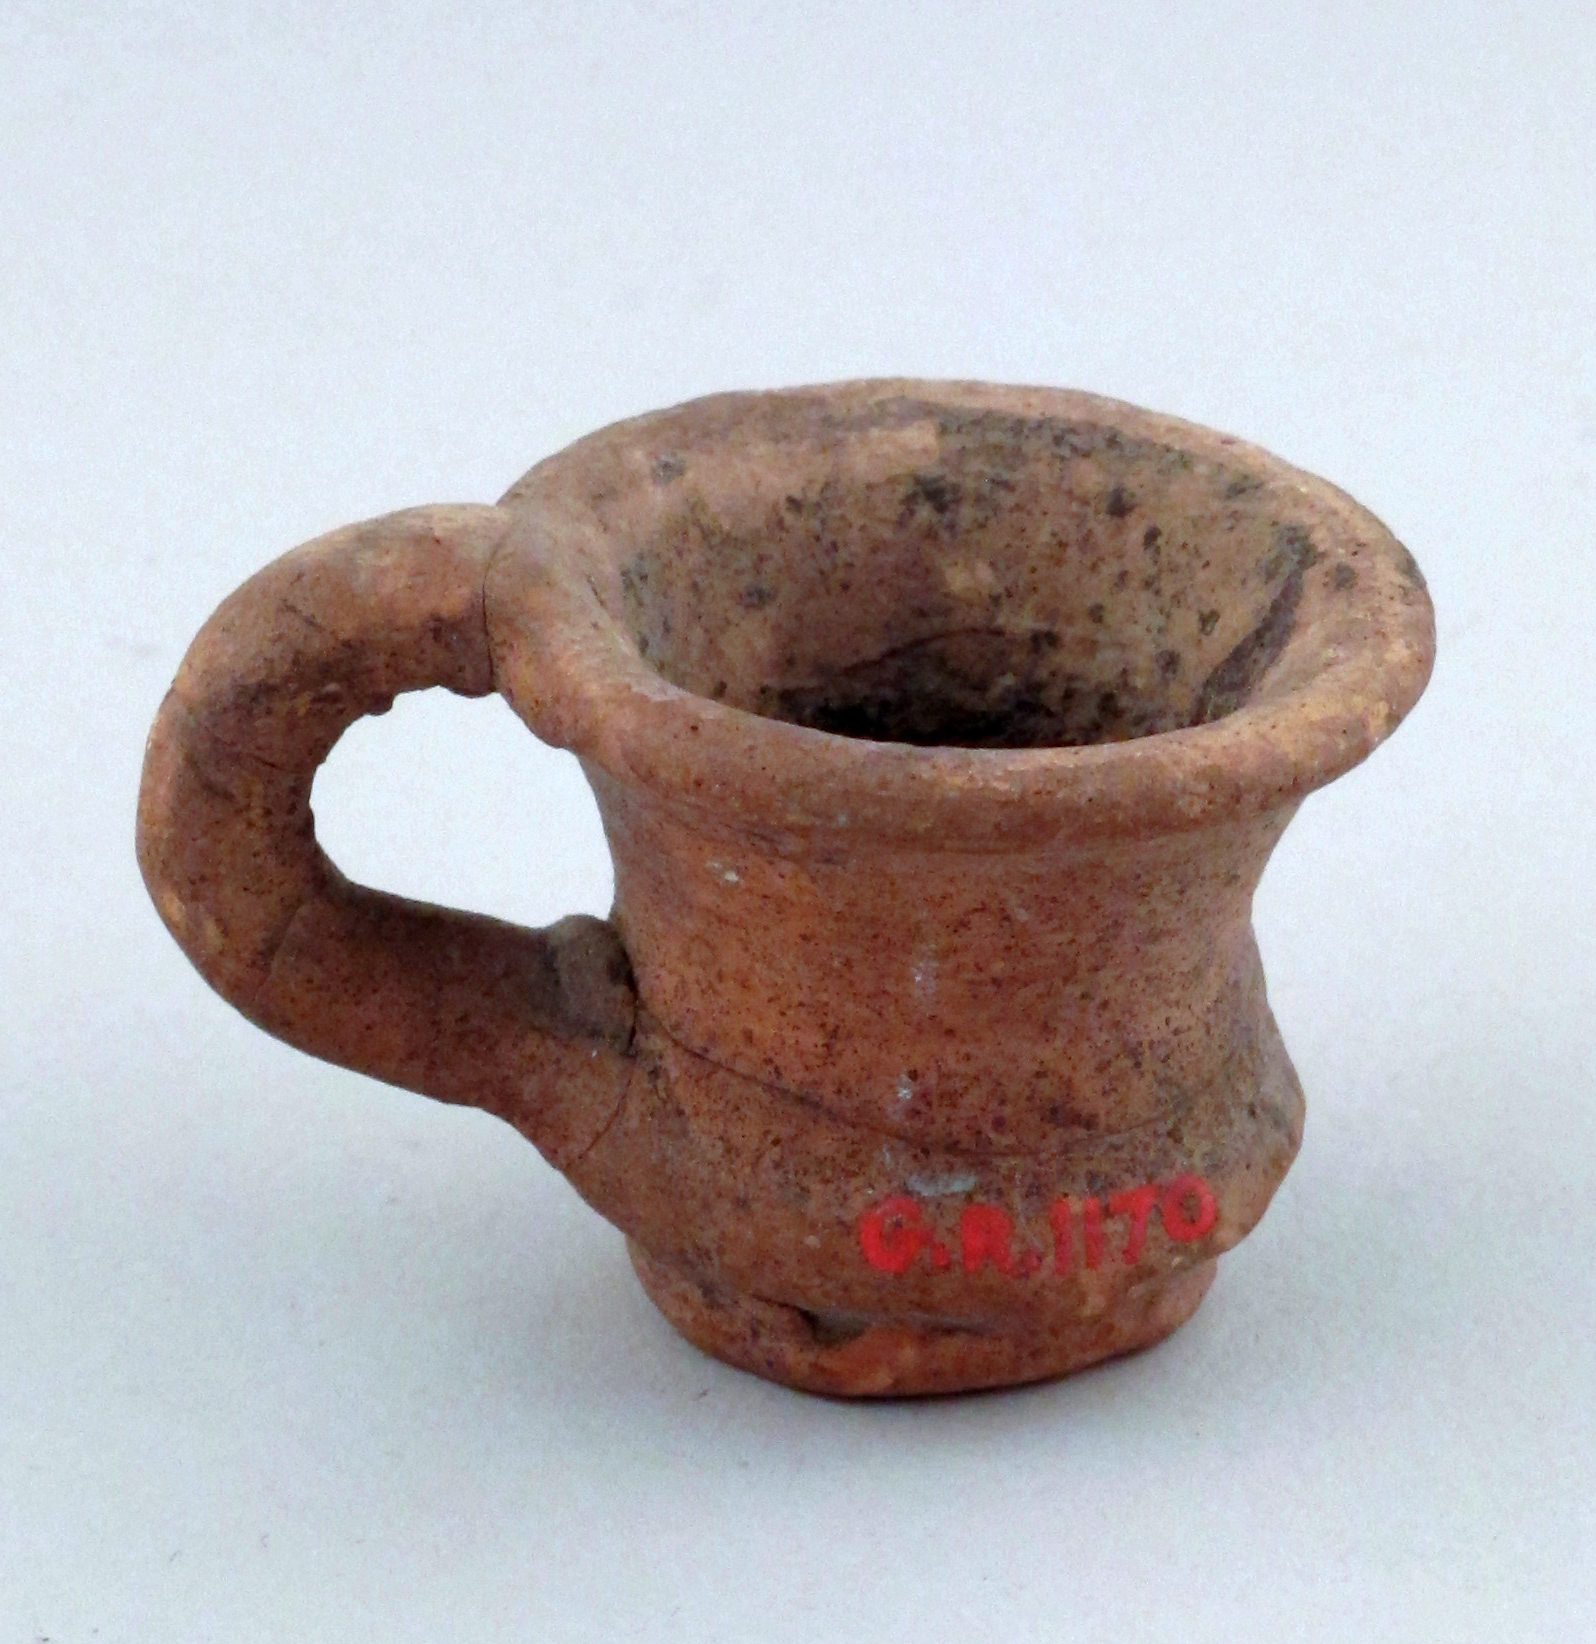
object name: cup, miniature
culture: etruscan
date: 300-101 BCE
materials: terracotta